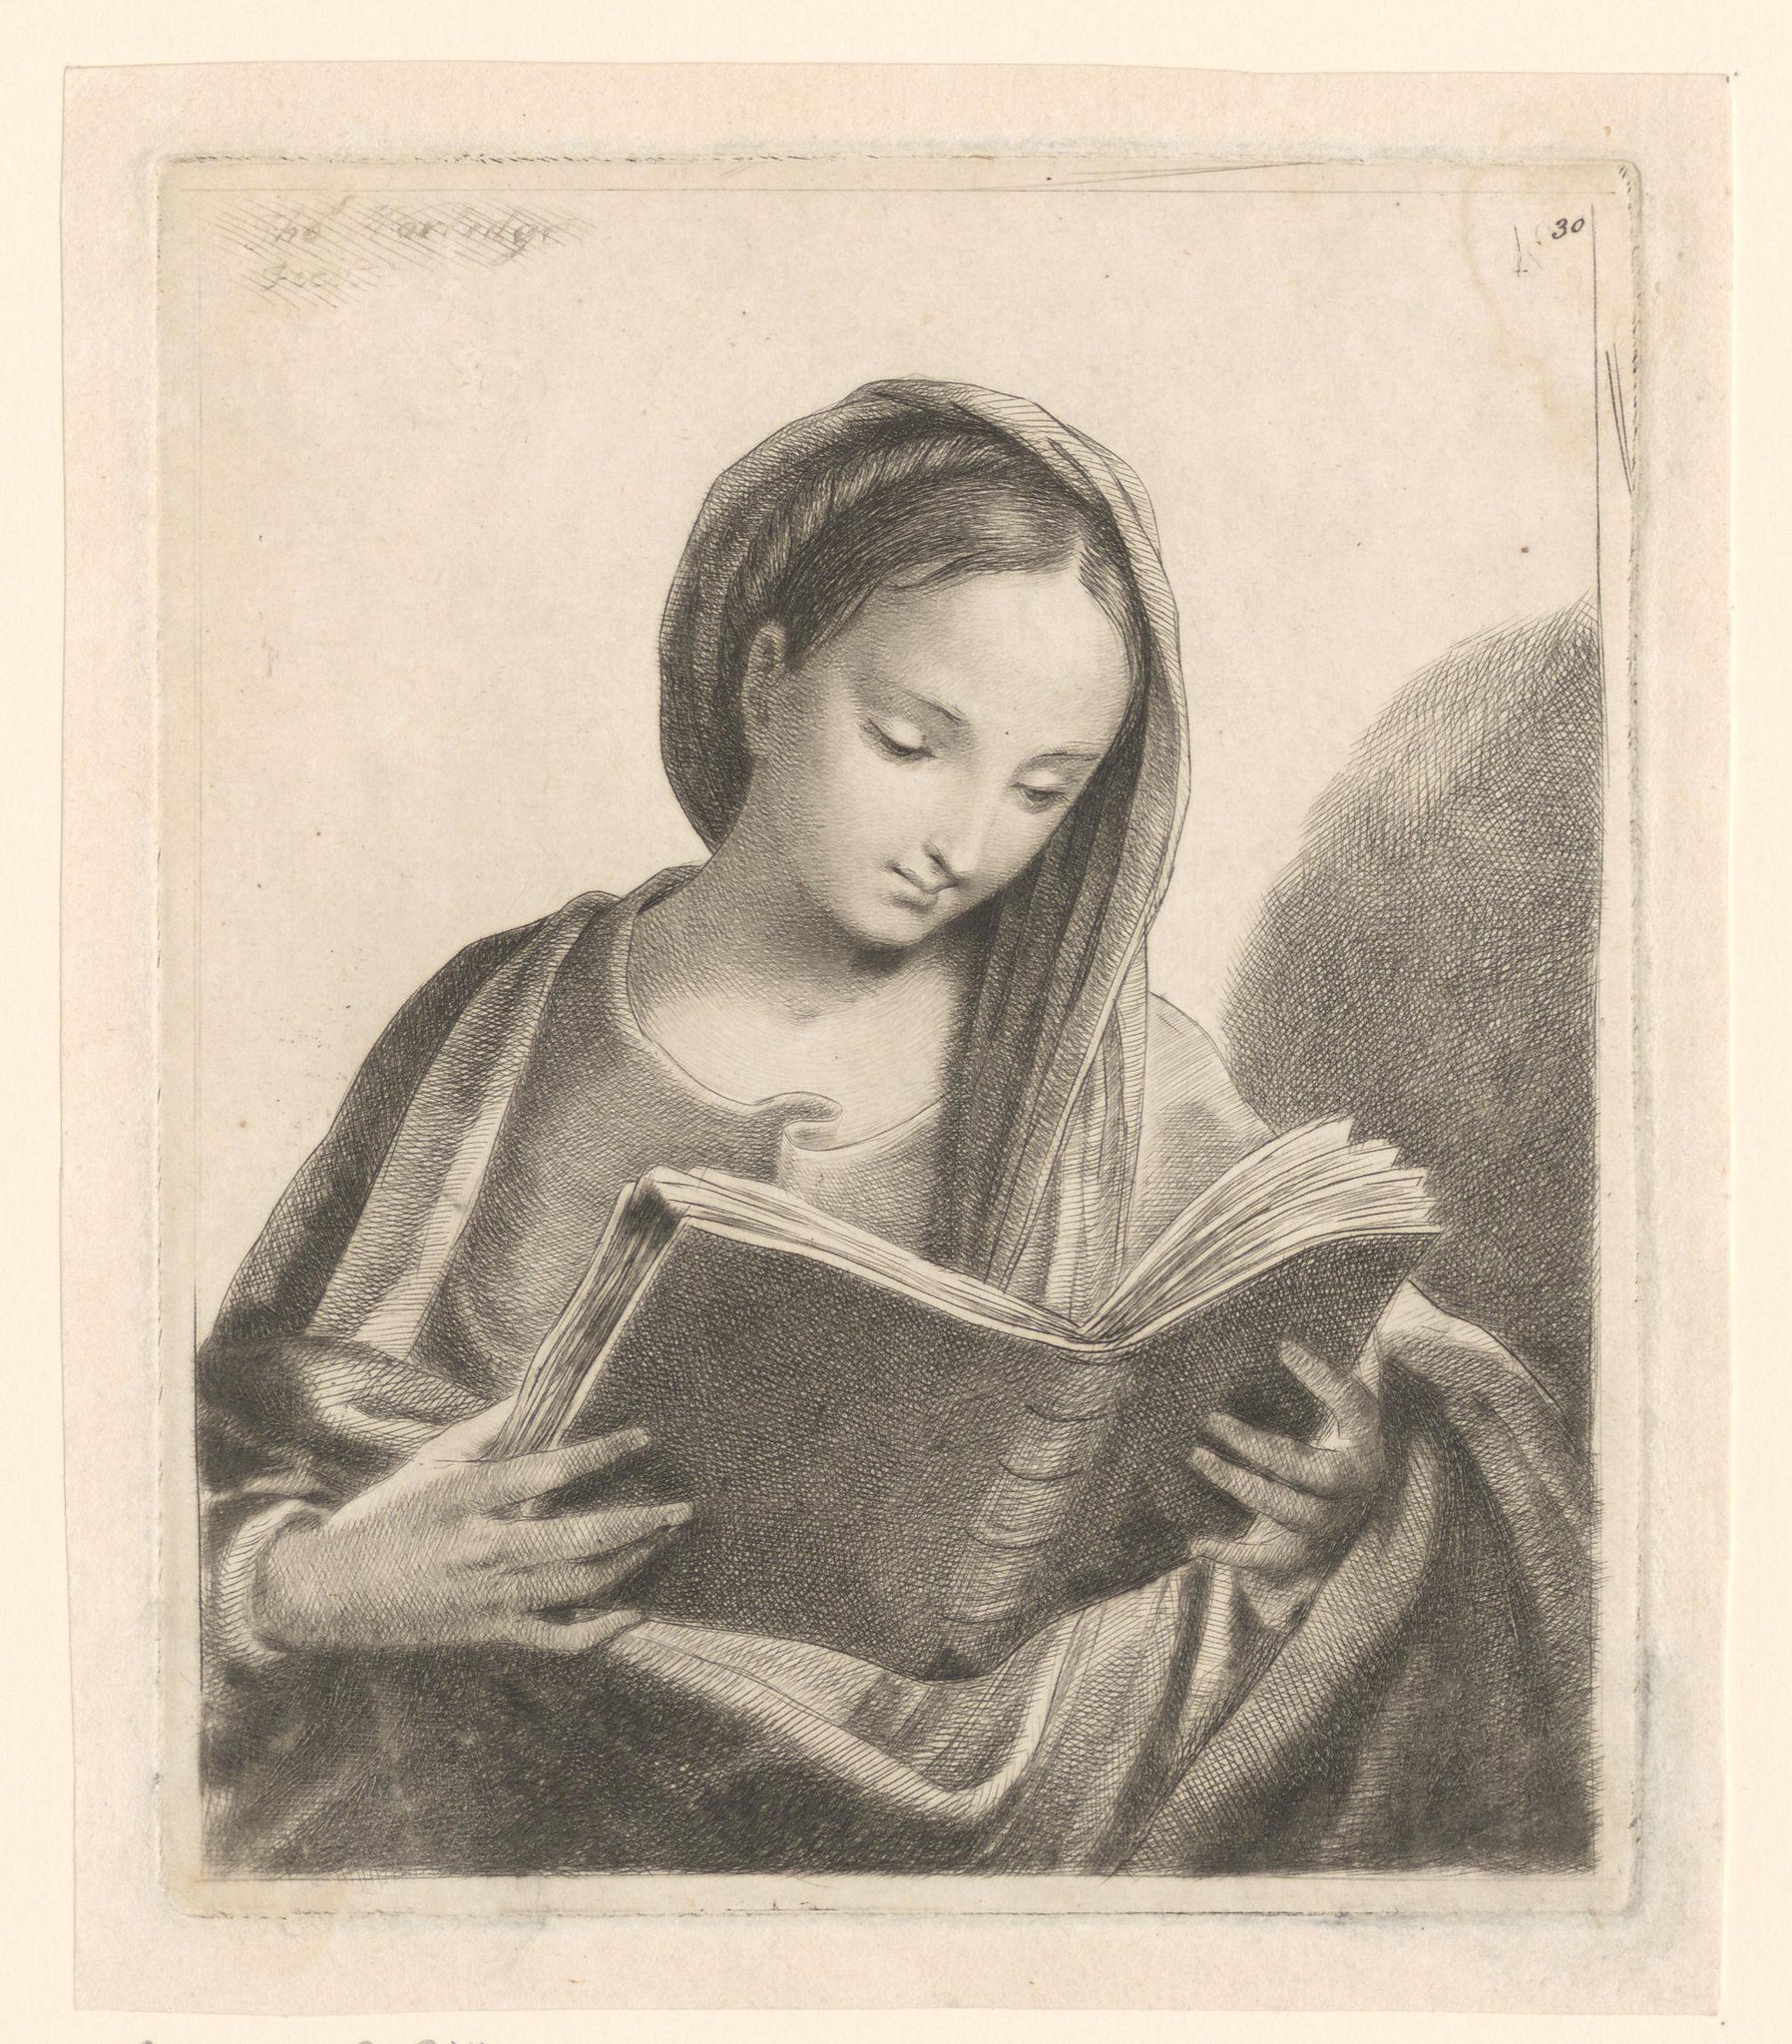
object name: print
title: Lezende gesluierde vrouw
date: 1710-1766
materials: paper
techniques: drypoint, etching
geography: italy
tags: reading, the virgin mary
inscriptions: collector's mark: Lugt 2228, collector's mark: Lugt 2760